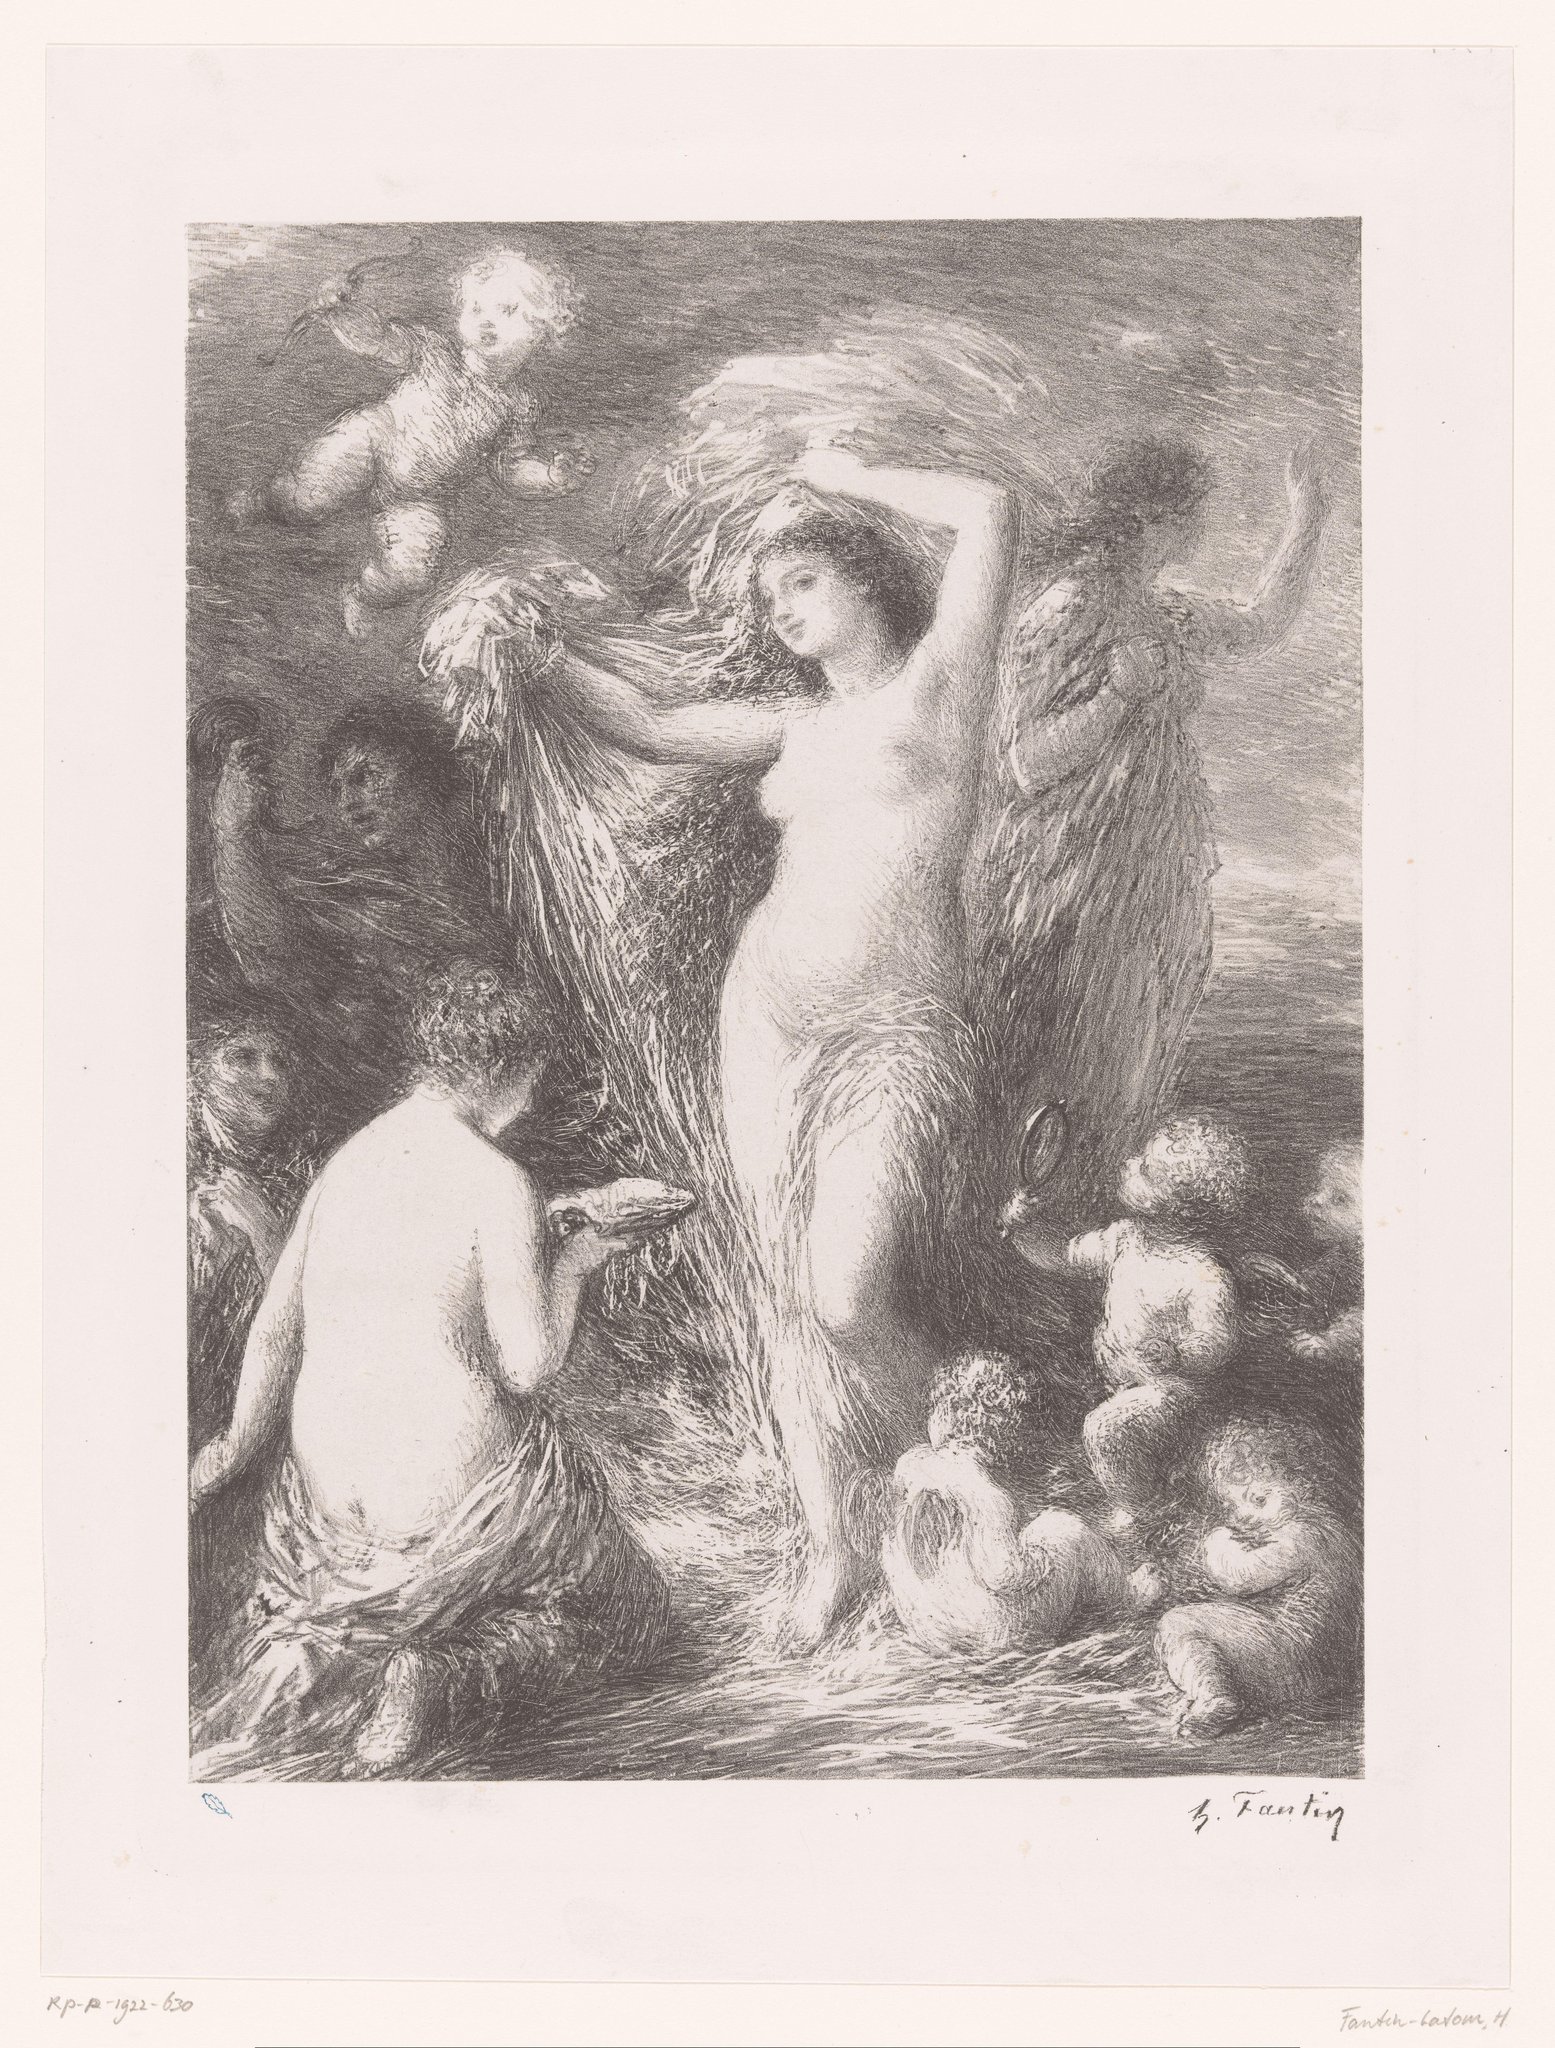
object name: print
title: Venus Anadyomene rijst op uit de zee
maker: henri fantin-latour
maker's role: draughtsman, print maker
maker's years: 1836-1904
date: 1898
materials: paper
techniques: lithography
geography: paris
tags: birth of venus; venus anadyomene: after uranus' castration venus rises from the sea wringing the water from her hair; usually she is awaited by the hours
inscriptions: stamp: Lugt 2853a, collector's mark: Lugt 2228a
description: Prent gebruikt voor: l'Album de l’Artiste, eerste trimester 1898.